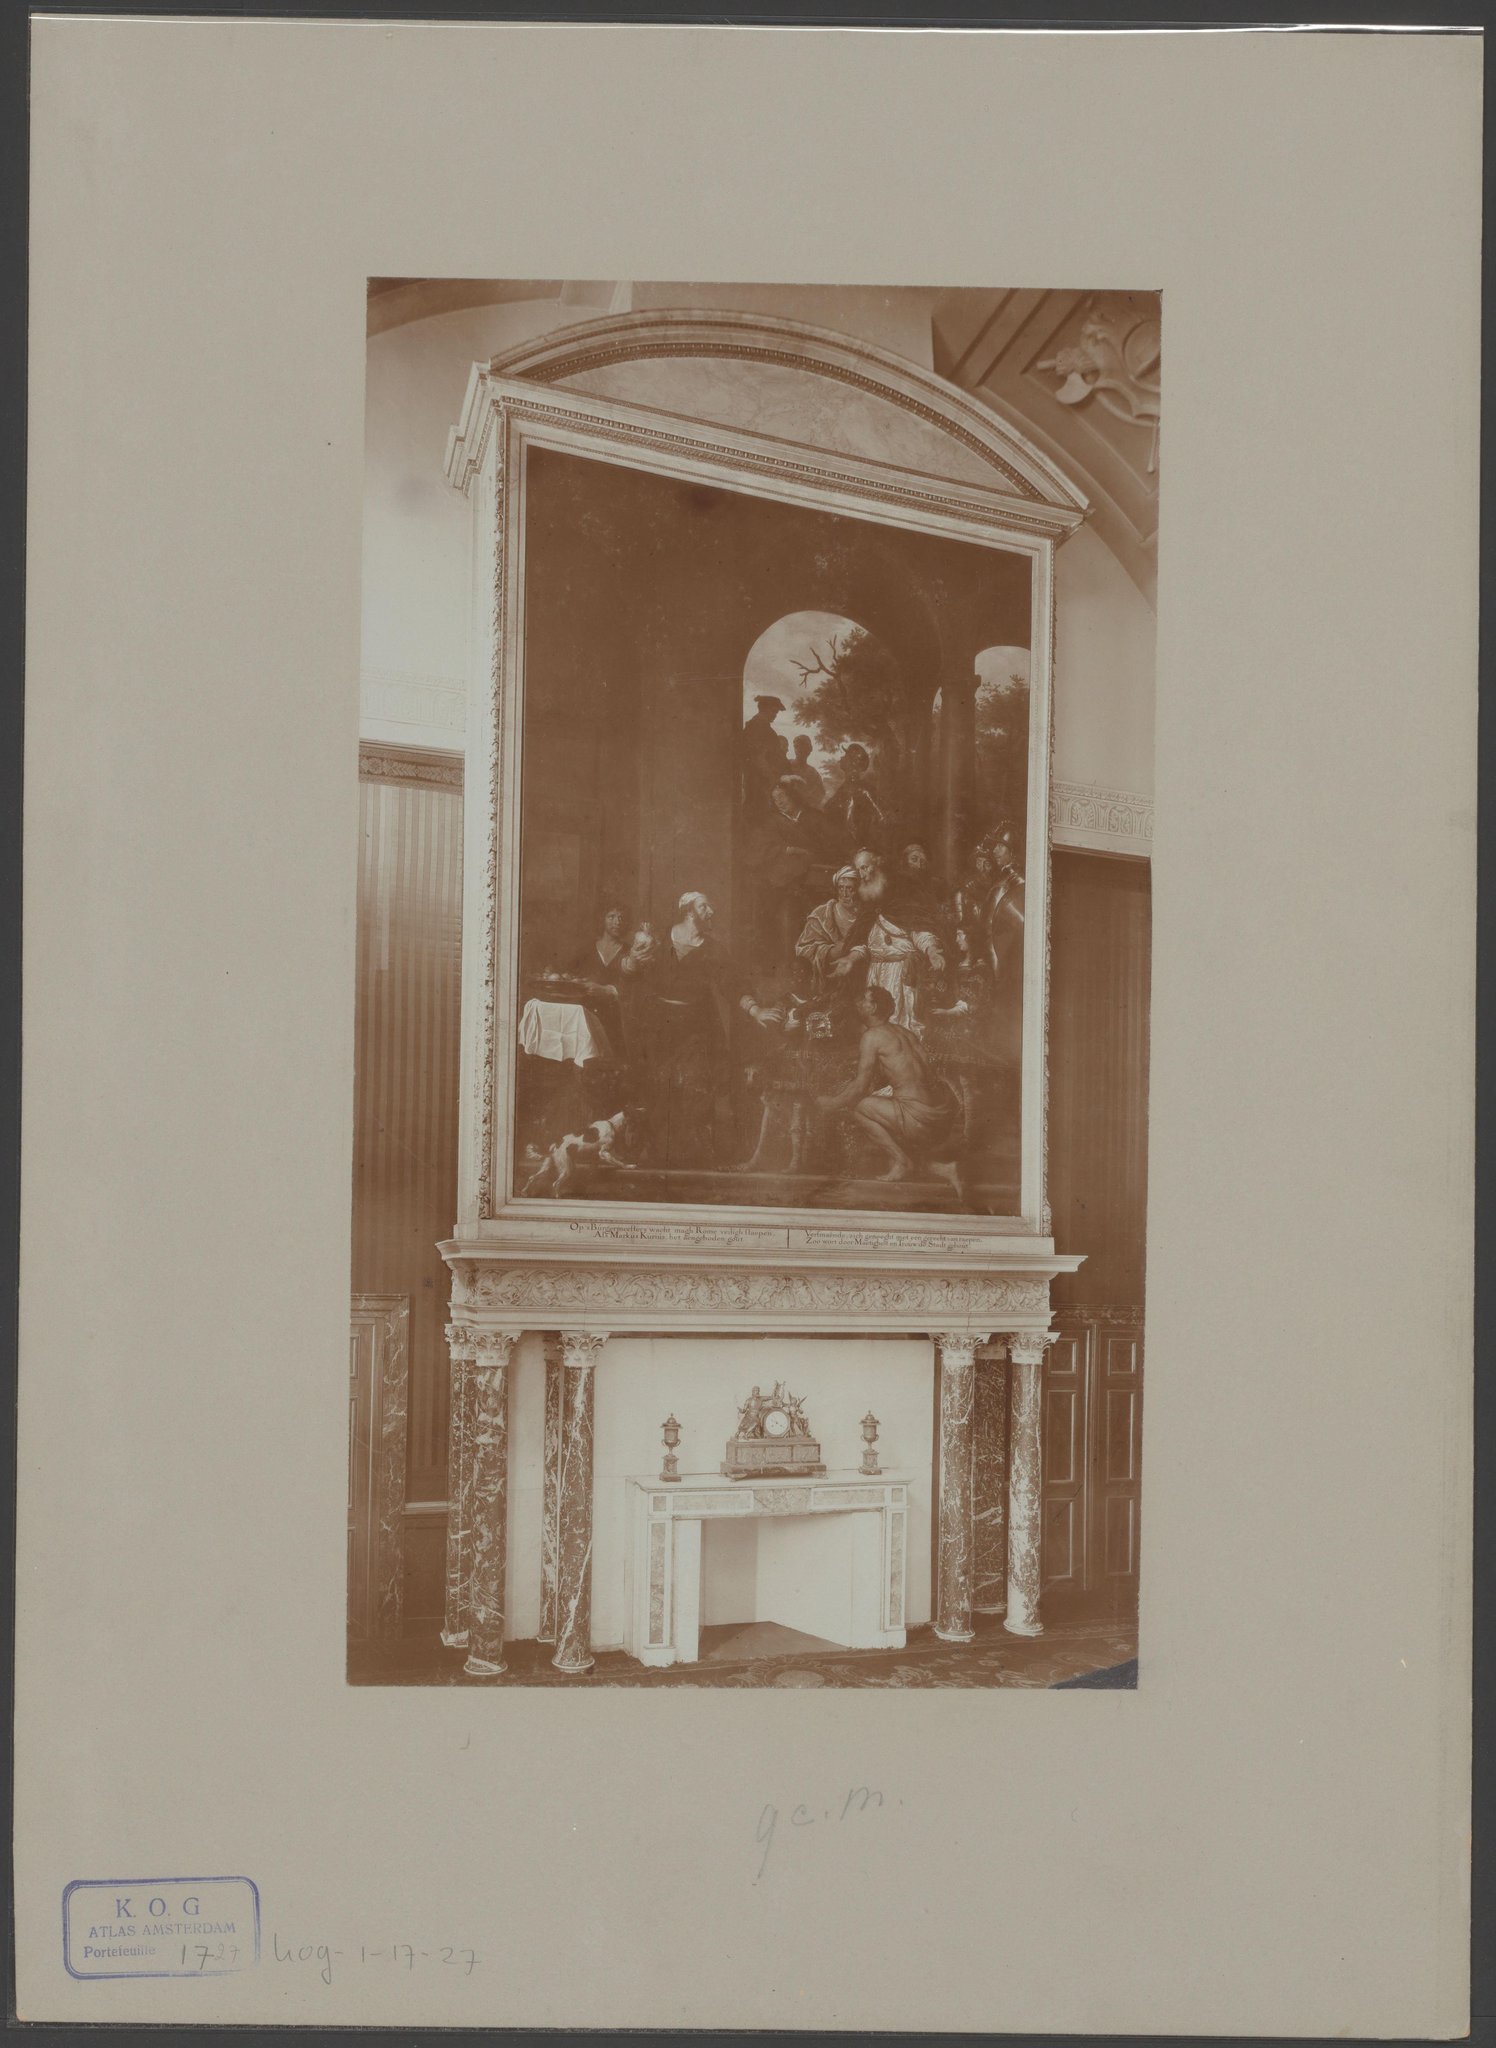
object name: photograph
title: Gezicht op de zuidelijke schoorsteen in de Burgemeesterskamer in het Paleis op de Dam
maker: Anonymous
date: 1865-1940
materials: paper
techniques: collodion silver print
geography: amsterdam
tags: chimney, mayor, burgomaster, townhall, chimney-piece, mantelpiece, royal palace of amsterdam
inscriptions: inscription: ‘Zuidelijke Schoorsteen / in het Burgemeestersvertrek’, collector's mark: ‘17.27’ Lugt 1641b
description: Onderwerpsrubriek binnen de Atlas Amsterdam: Nieuwe Stadhuis, van binnen: Groote zaal, Raadkamer, Schepenkamer, Troonzaal, Mozeszaal, Zitkamer.